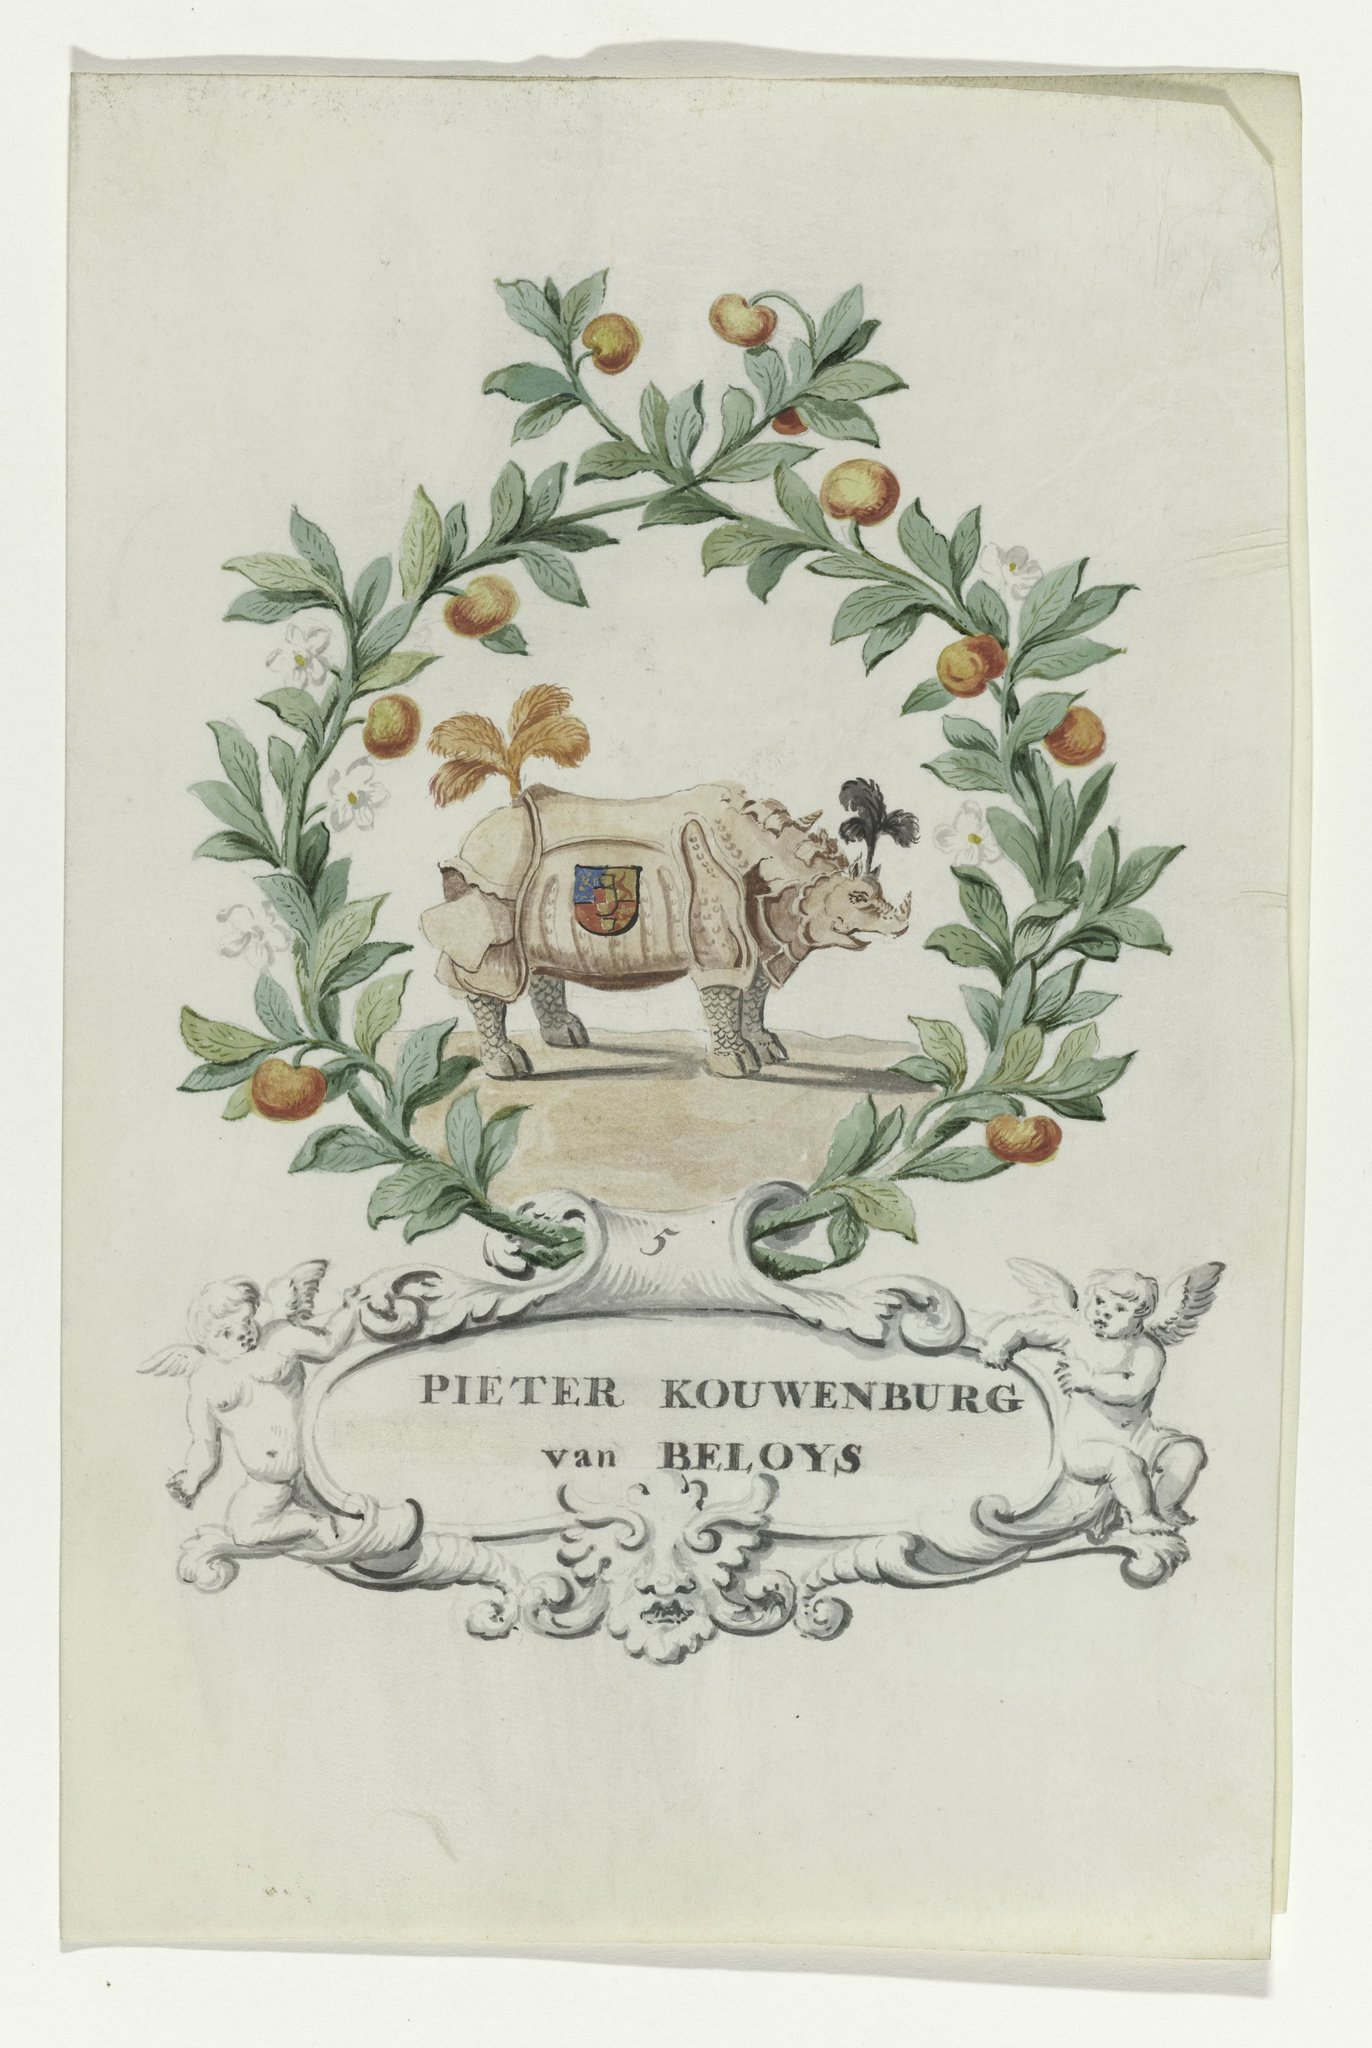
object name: cartoon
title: Regtspleging van Oldenbarnevelt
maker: Anonymous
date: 1710-1720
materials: ink, parchment, watercolor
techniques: brush, pen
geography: netherlands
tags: the hague, johan van oldenbarnevelt, caricatures (human types), hoofed animals: rhinoceros, bad, corrupt judge, political caricatures and satires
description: Spotprent van Pieter Kouwenburg van Beloys, rechter van Van Oldenbarnevelt. Neushoorn met pluimen in krans van bloemen, kersen en bladeren. Daaronder cartouche met aan weerszijden twee putti. In cartouche naam en daarboven nr. 5. Behorende bij serie aquarellen in boek.